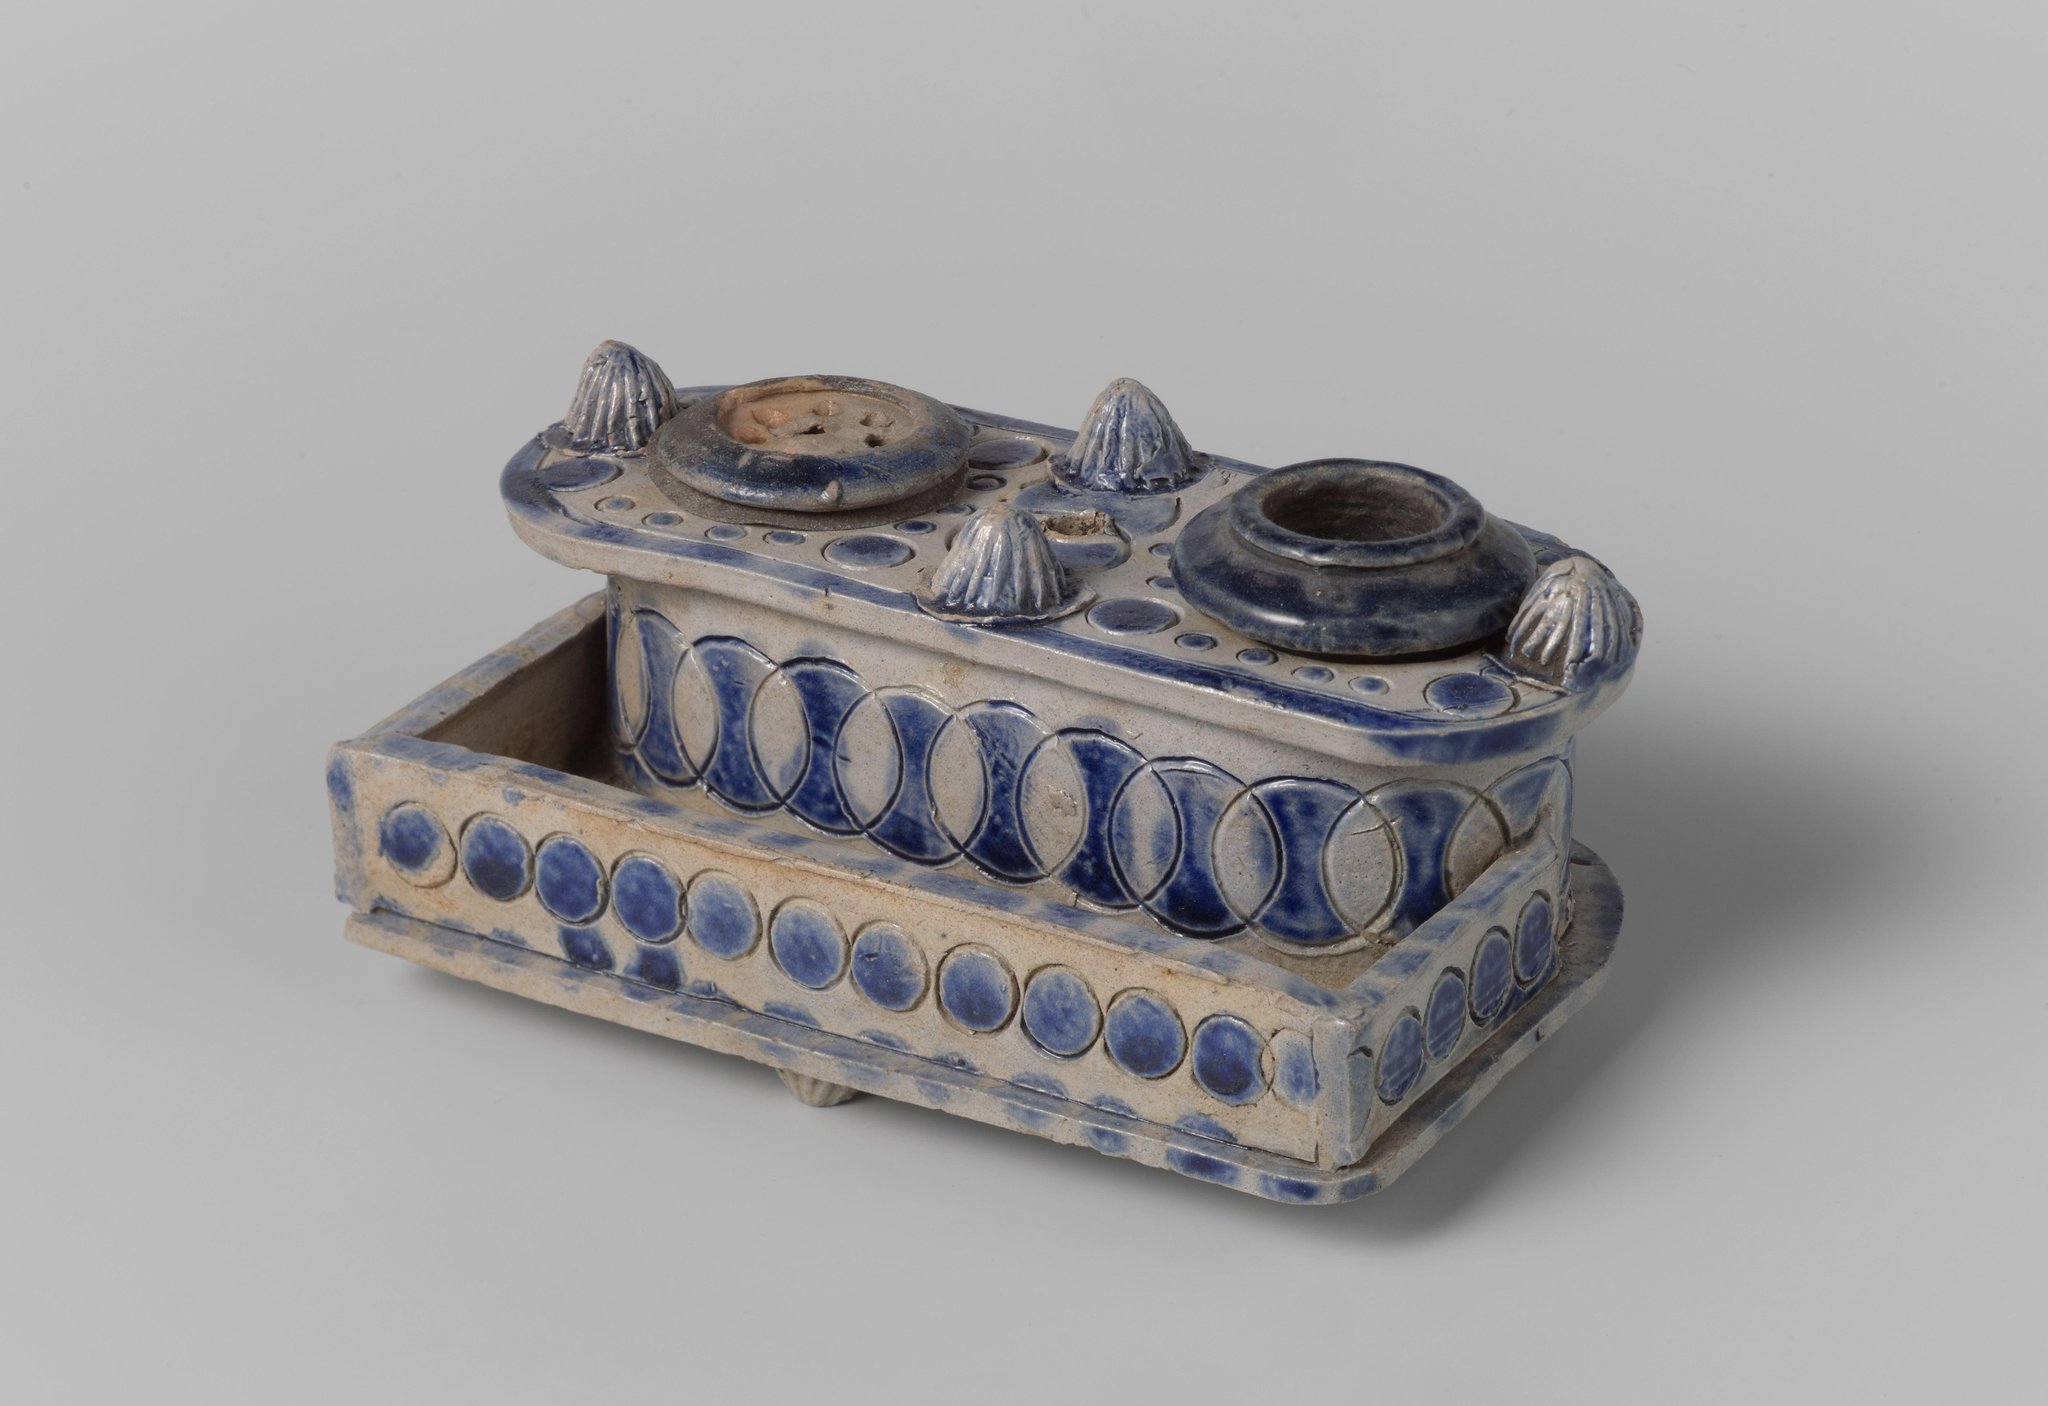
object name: inkstand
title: Ink stand with circles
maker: Anonymous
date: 1750-1799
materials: cobalt, glaze, stoneware, tin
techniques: printing, firing, forming, vitrification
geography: westerwald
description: Inkstel van steengoed op drie lage voeten, met een pennenbak en twee houders voor de inktpot en de zandstrooier. Daarbij zit in één houder een tinnen bakje. Gedeeltelijk bedekt met kobaltblauw. De voor- en achterzijde met een decoratie van gestempelde, aaneengeschakelde cirkels. Op de buitenwand van de pennenbak en op de bovenzijde gestempelde cirkels. Op de bovenzijde viermaal een gemodelleerde 'klinknagel'. Westerwald.